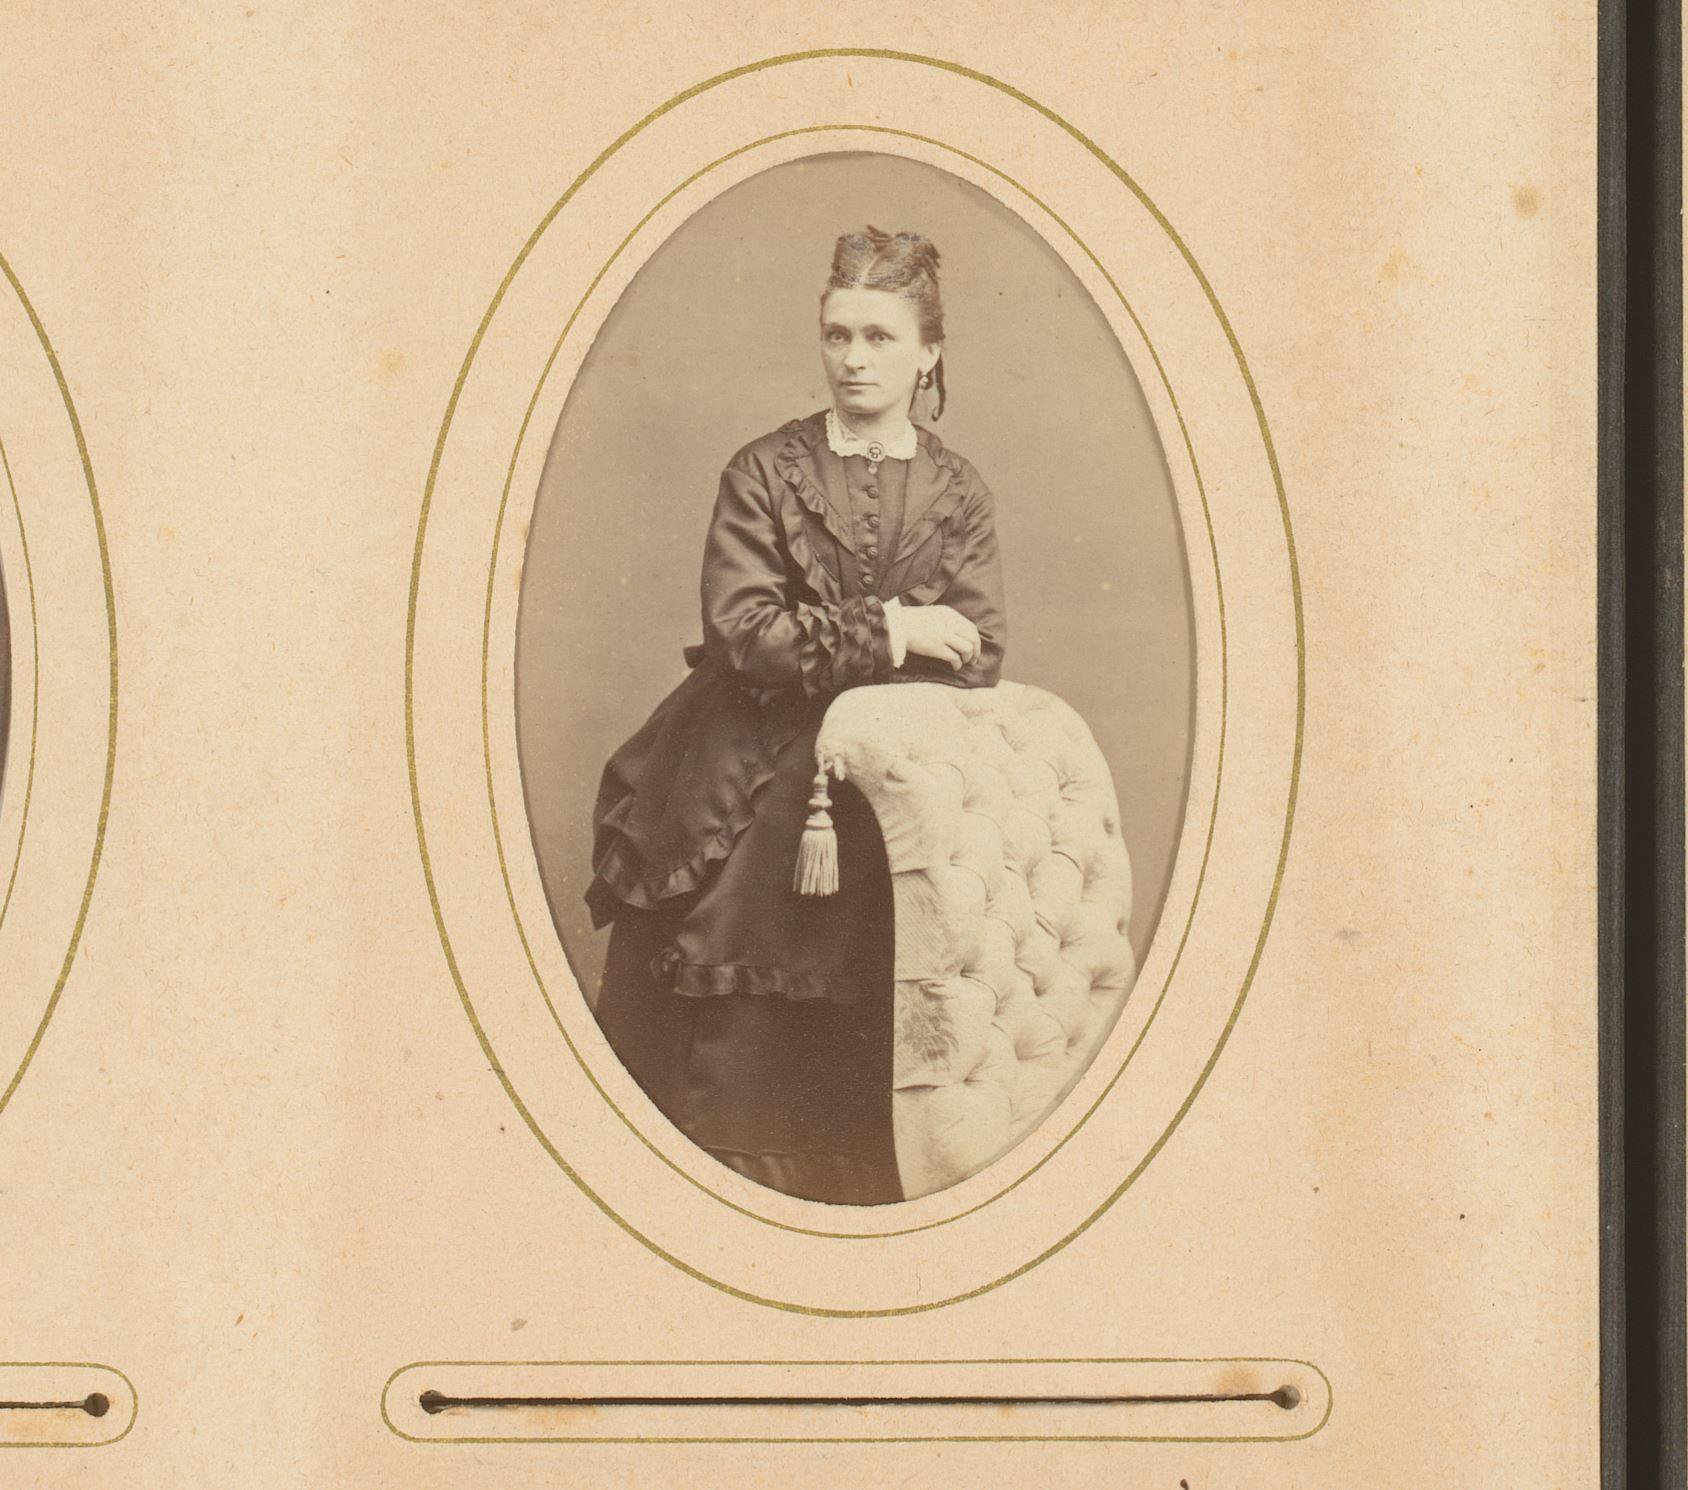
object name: photograph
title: Portret van een staande vrouw, leunend op de leuning van een fauteuil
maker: albert greiner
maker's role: fotograaf, fotostudio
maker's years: 1833-1890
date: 1861-1874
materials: cardboard, photographic support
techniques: albumen print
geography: amsterdam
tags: historical persons - bb - woman, standing figure - aa - female human figure, chair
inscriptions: inscription: ‘A. Greiner/ Photograaf/ NIEUWENDIJK L. 87/ AMSTERDAM’, number: ‘6.’